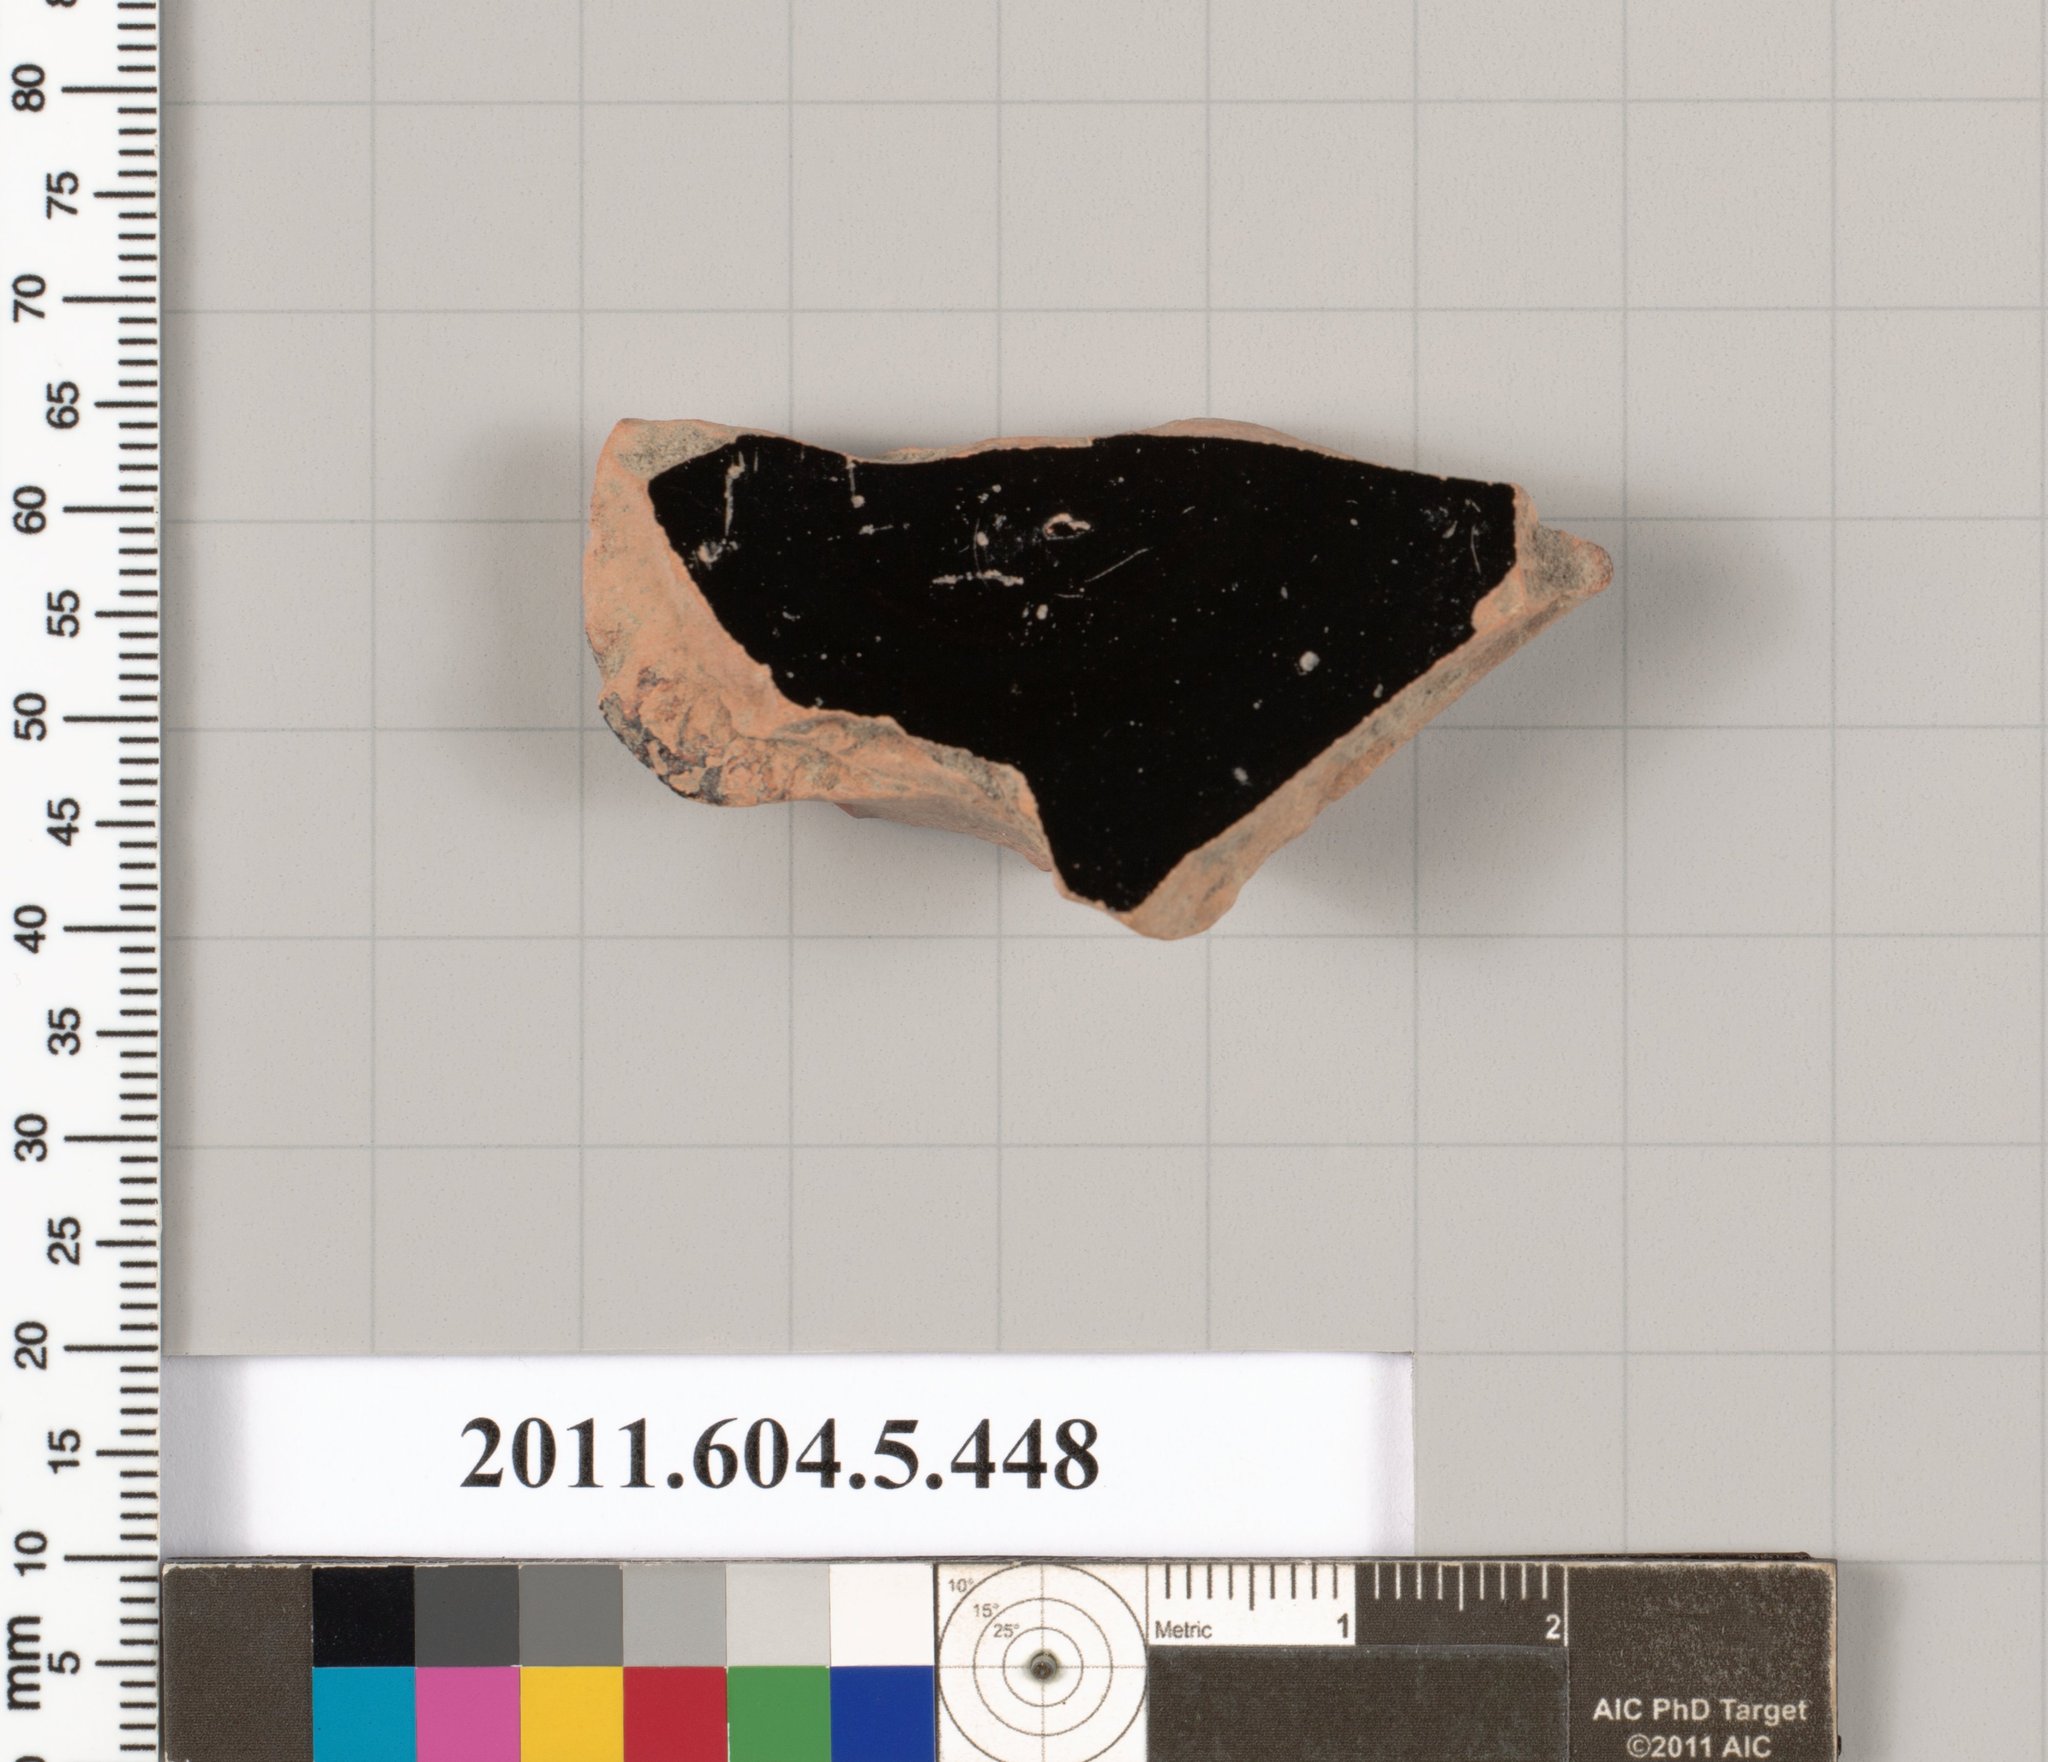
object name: kylix fragment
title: Terracotta fragment of a kylix (drinking cup)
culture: greek, attic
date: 600-401 BCE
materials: terracotta